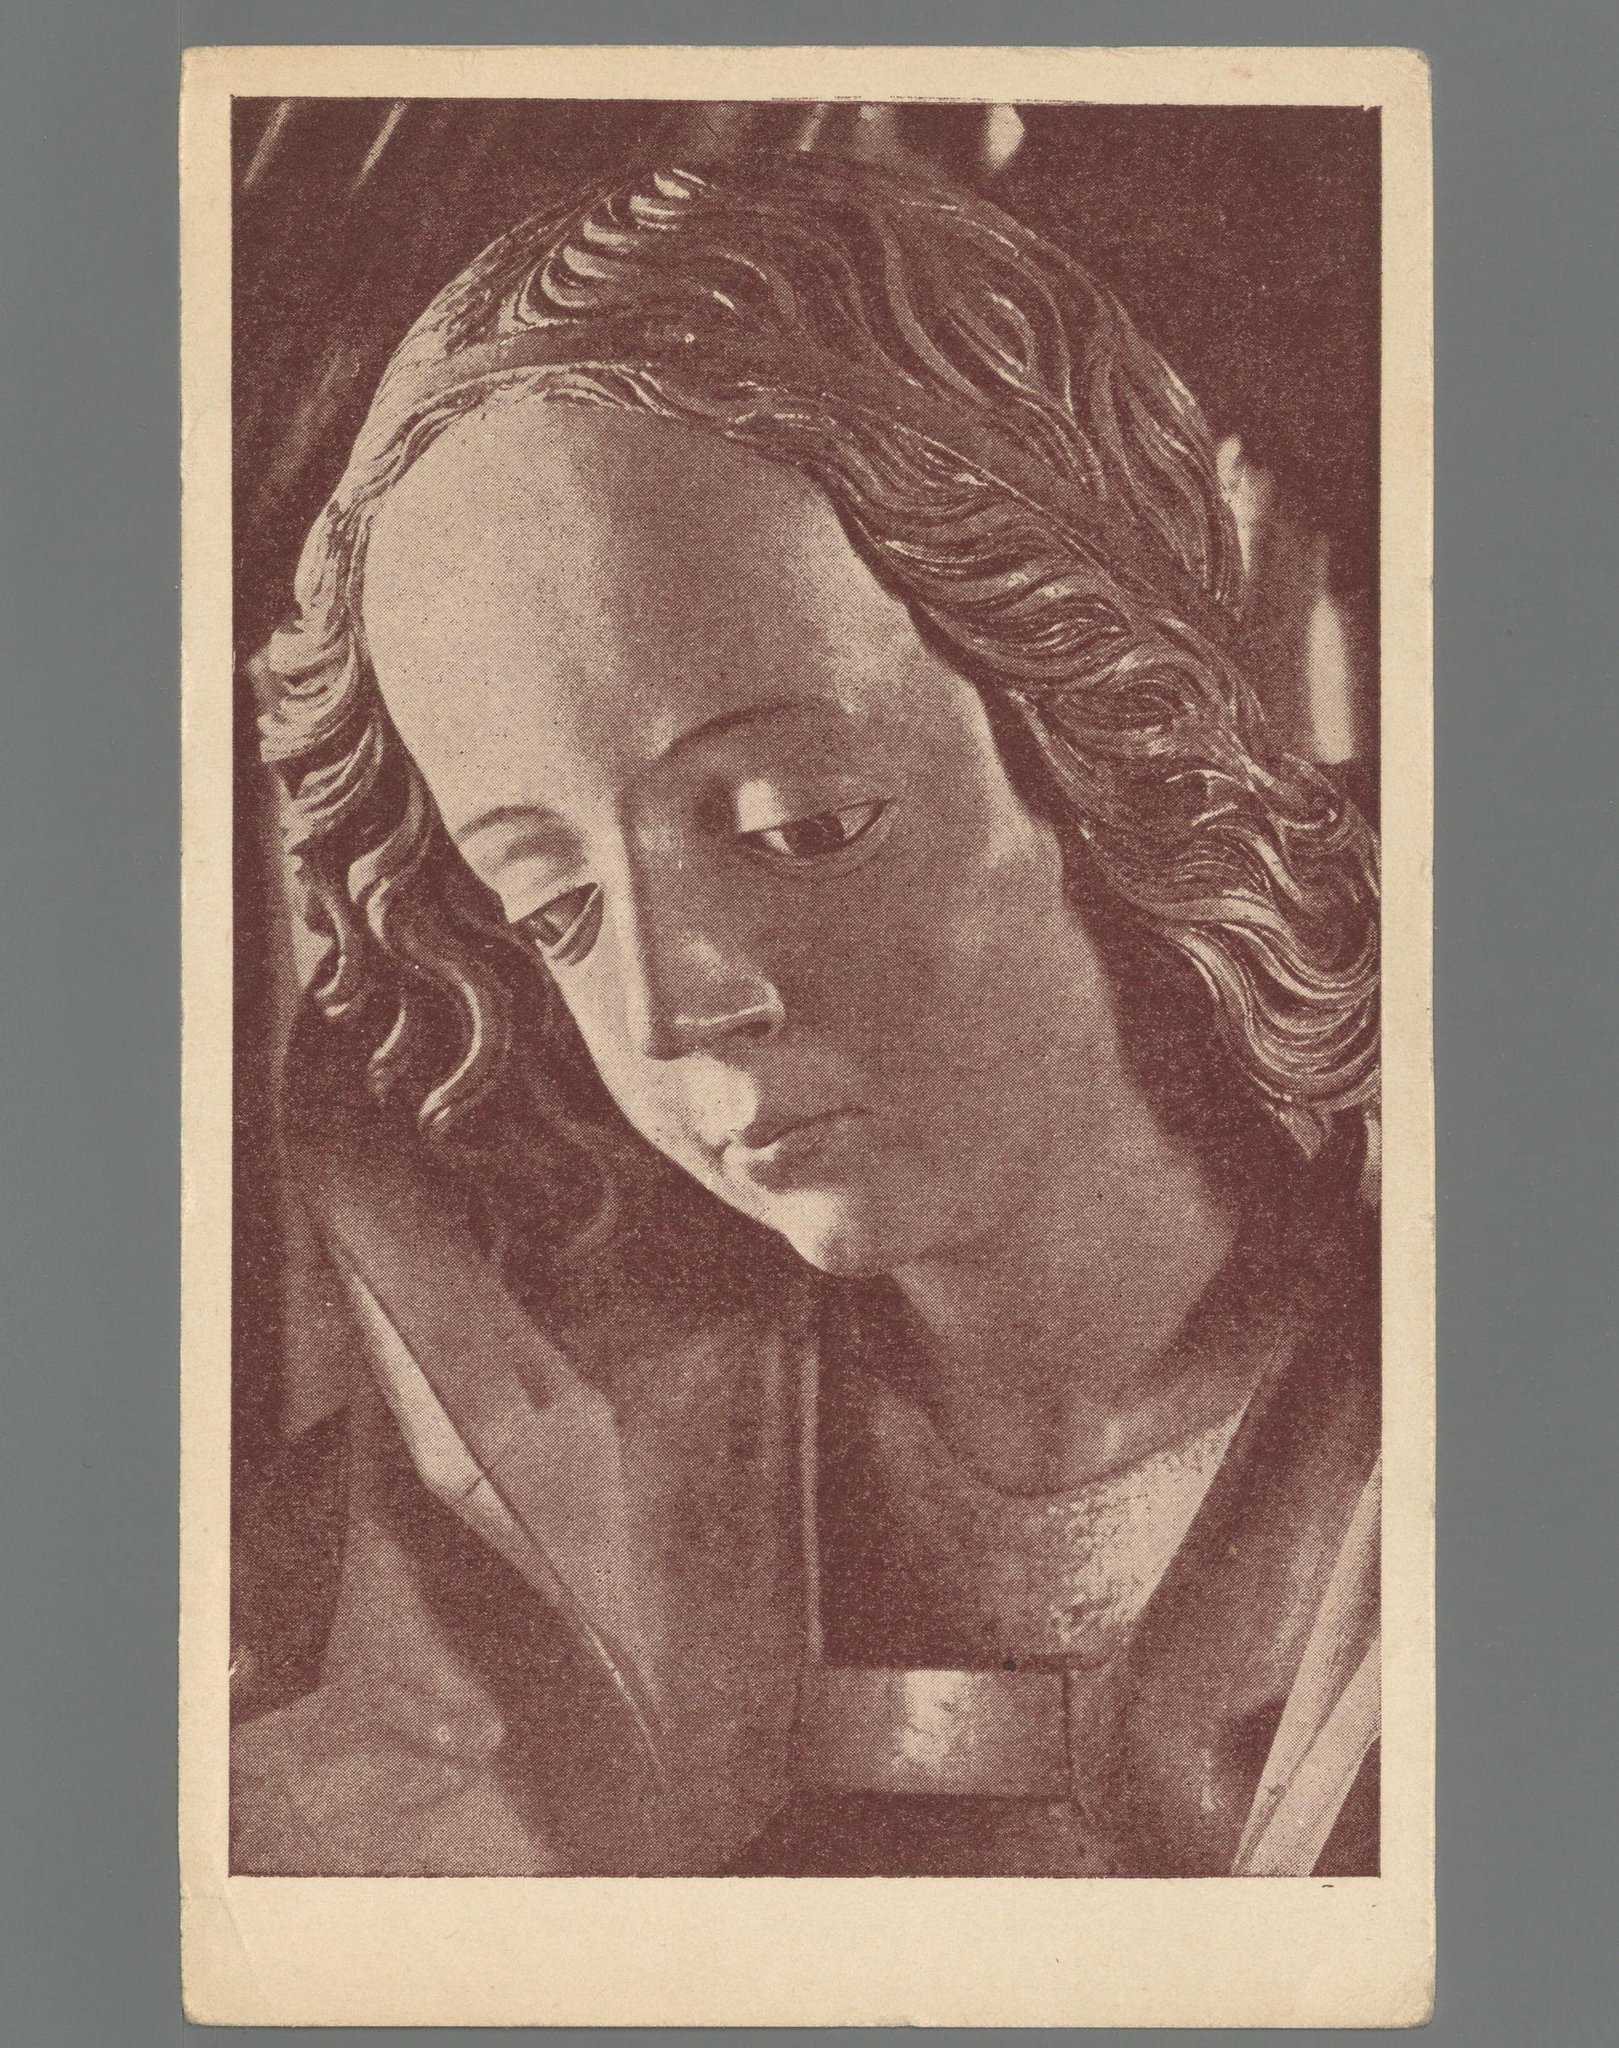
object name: ansichtkaart, prentbriefkaart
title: Beeldhouwwerk door Veit Stoss op het hoofdaltaar in de Mariakerk te Krakau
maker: Anonymous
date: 1920-1960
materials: cardboard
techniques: autotype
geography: krakow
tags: interior of church, sculpture